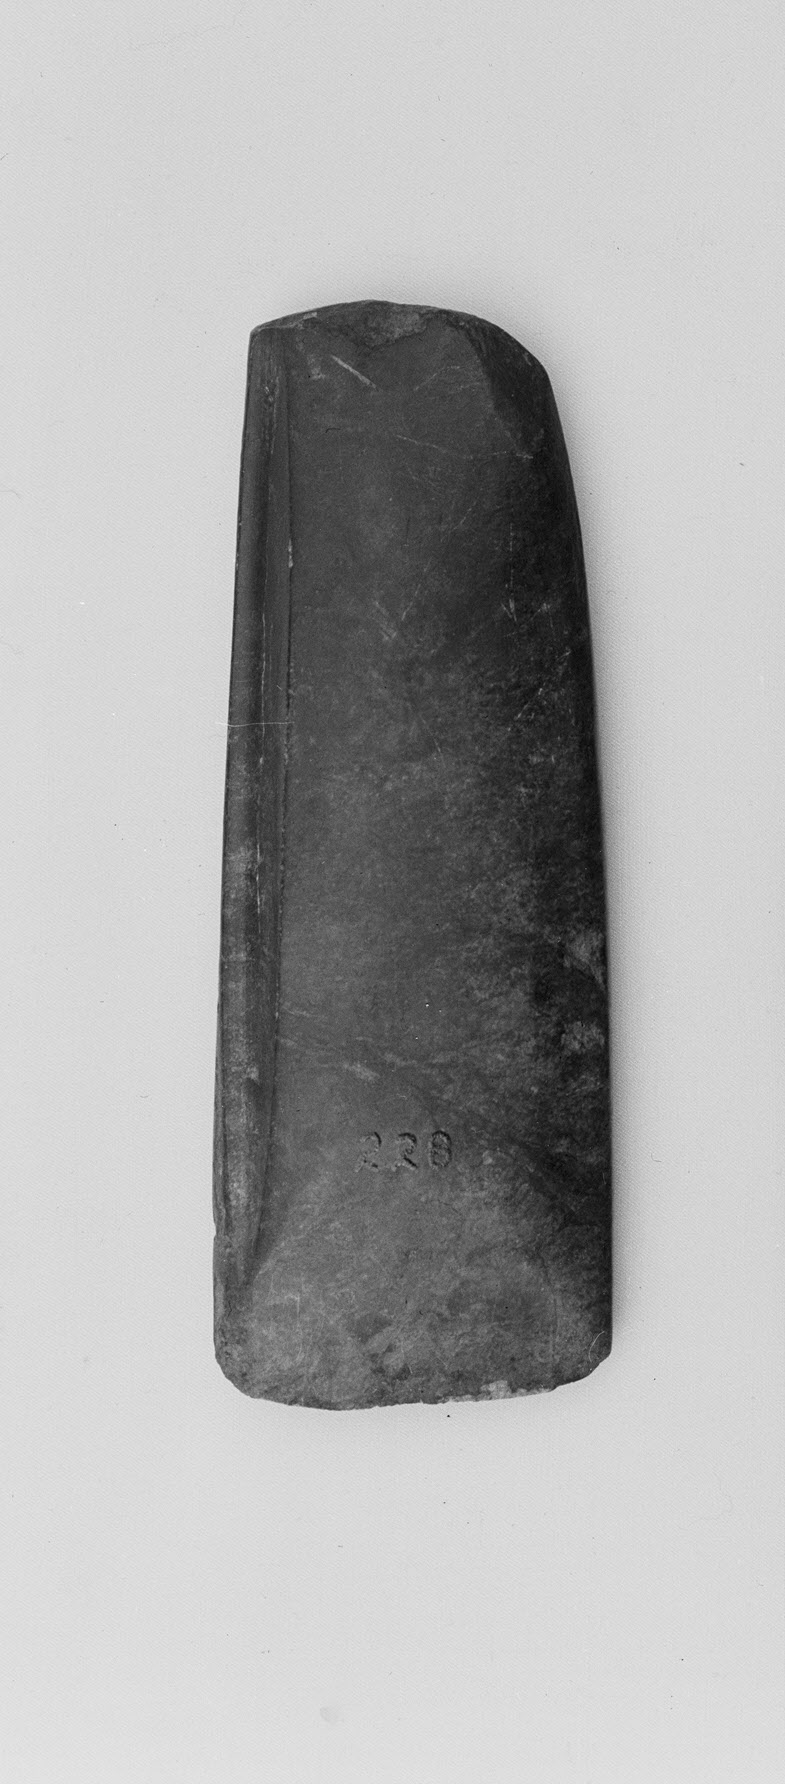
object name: axe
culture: canadian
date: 1902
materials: jade